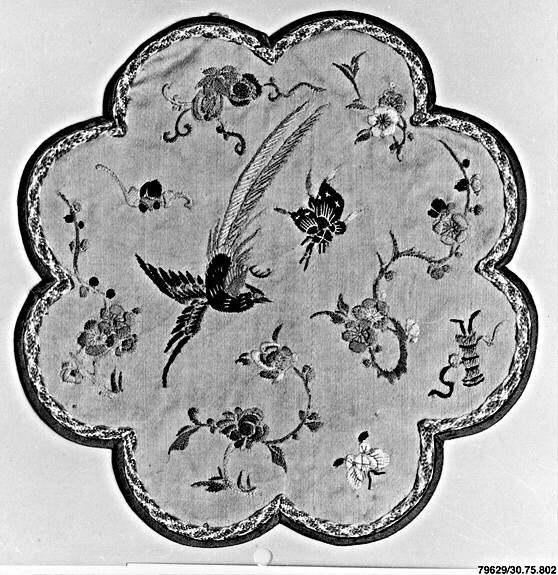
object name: medallion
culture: chinese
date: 1644-1911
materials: silk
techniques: bookbinding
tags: flowers